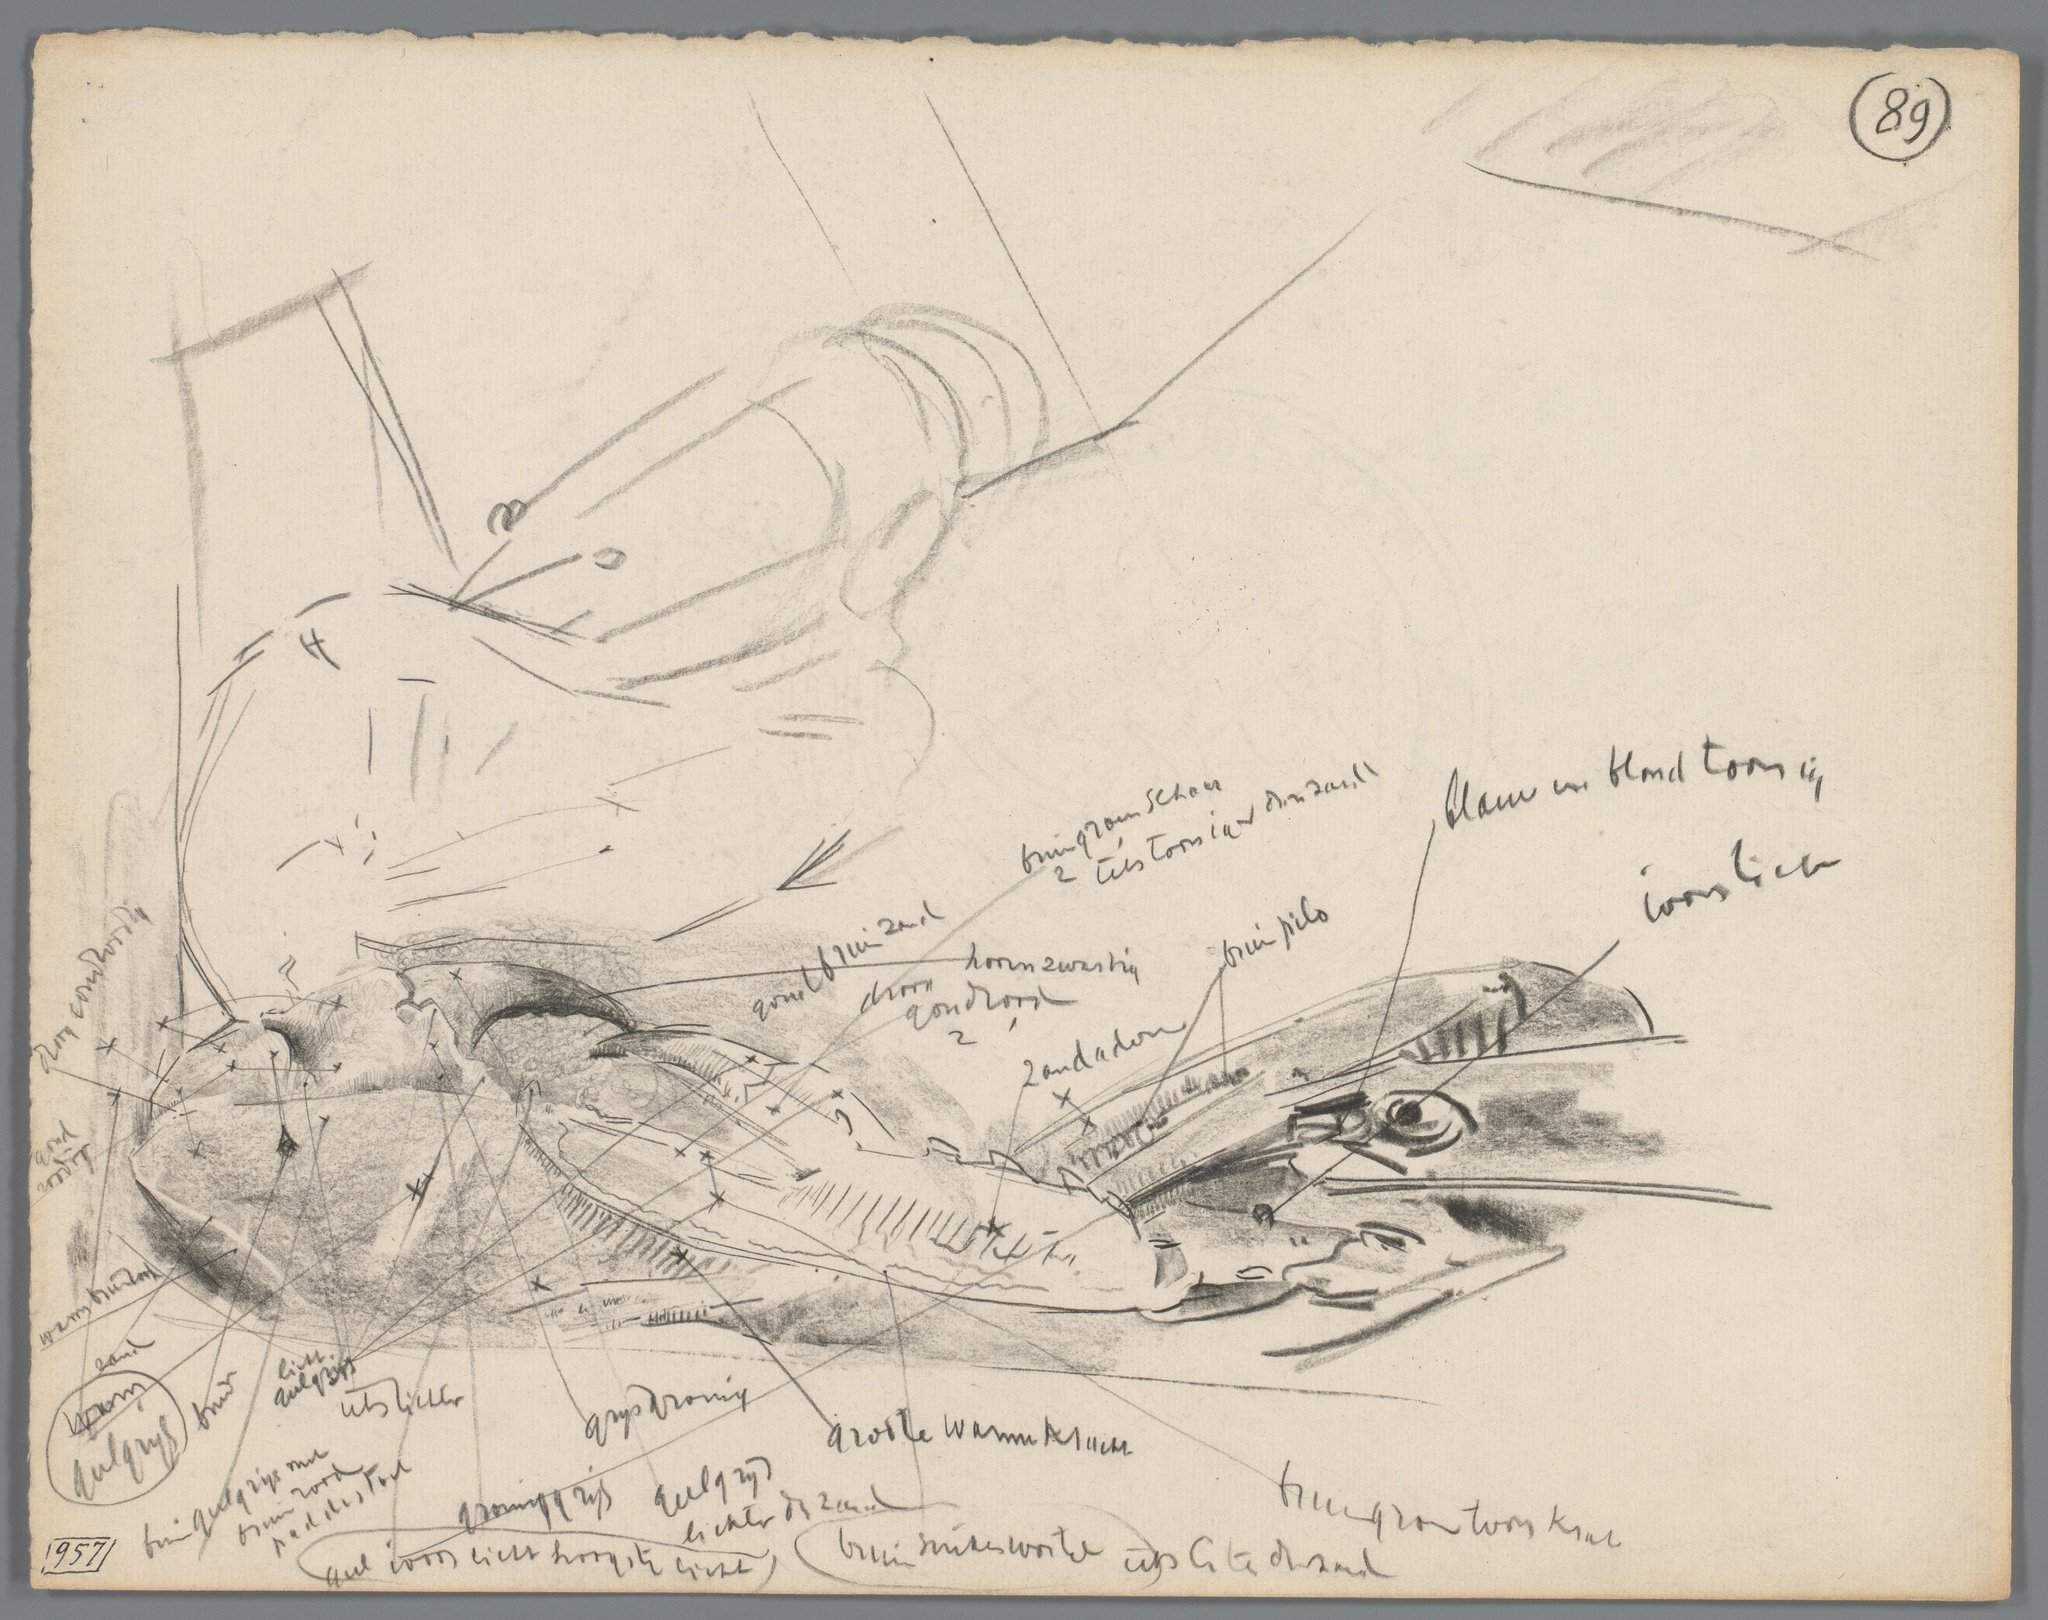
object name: drawing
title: Studie van een kreeft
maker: gerrit willem dijsselhof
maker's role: designer, draughtsman, print maker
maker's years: 1866-1924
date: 1876-1924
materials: chalk, paper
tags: crustaceans: lobster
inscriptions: number: ‘957’, watermark, number: ‘89’